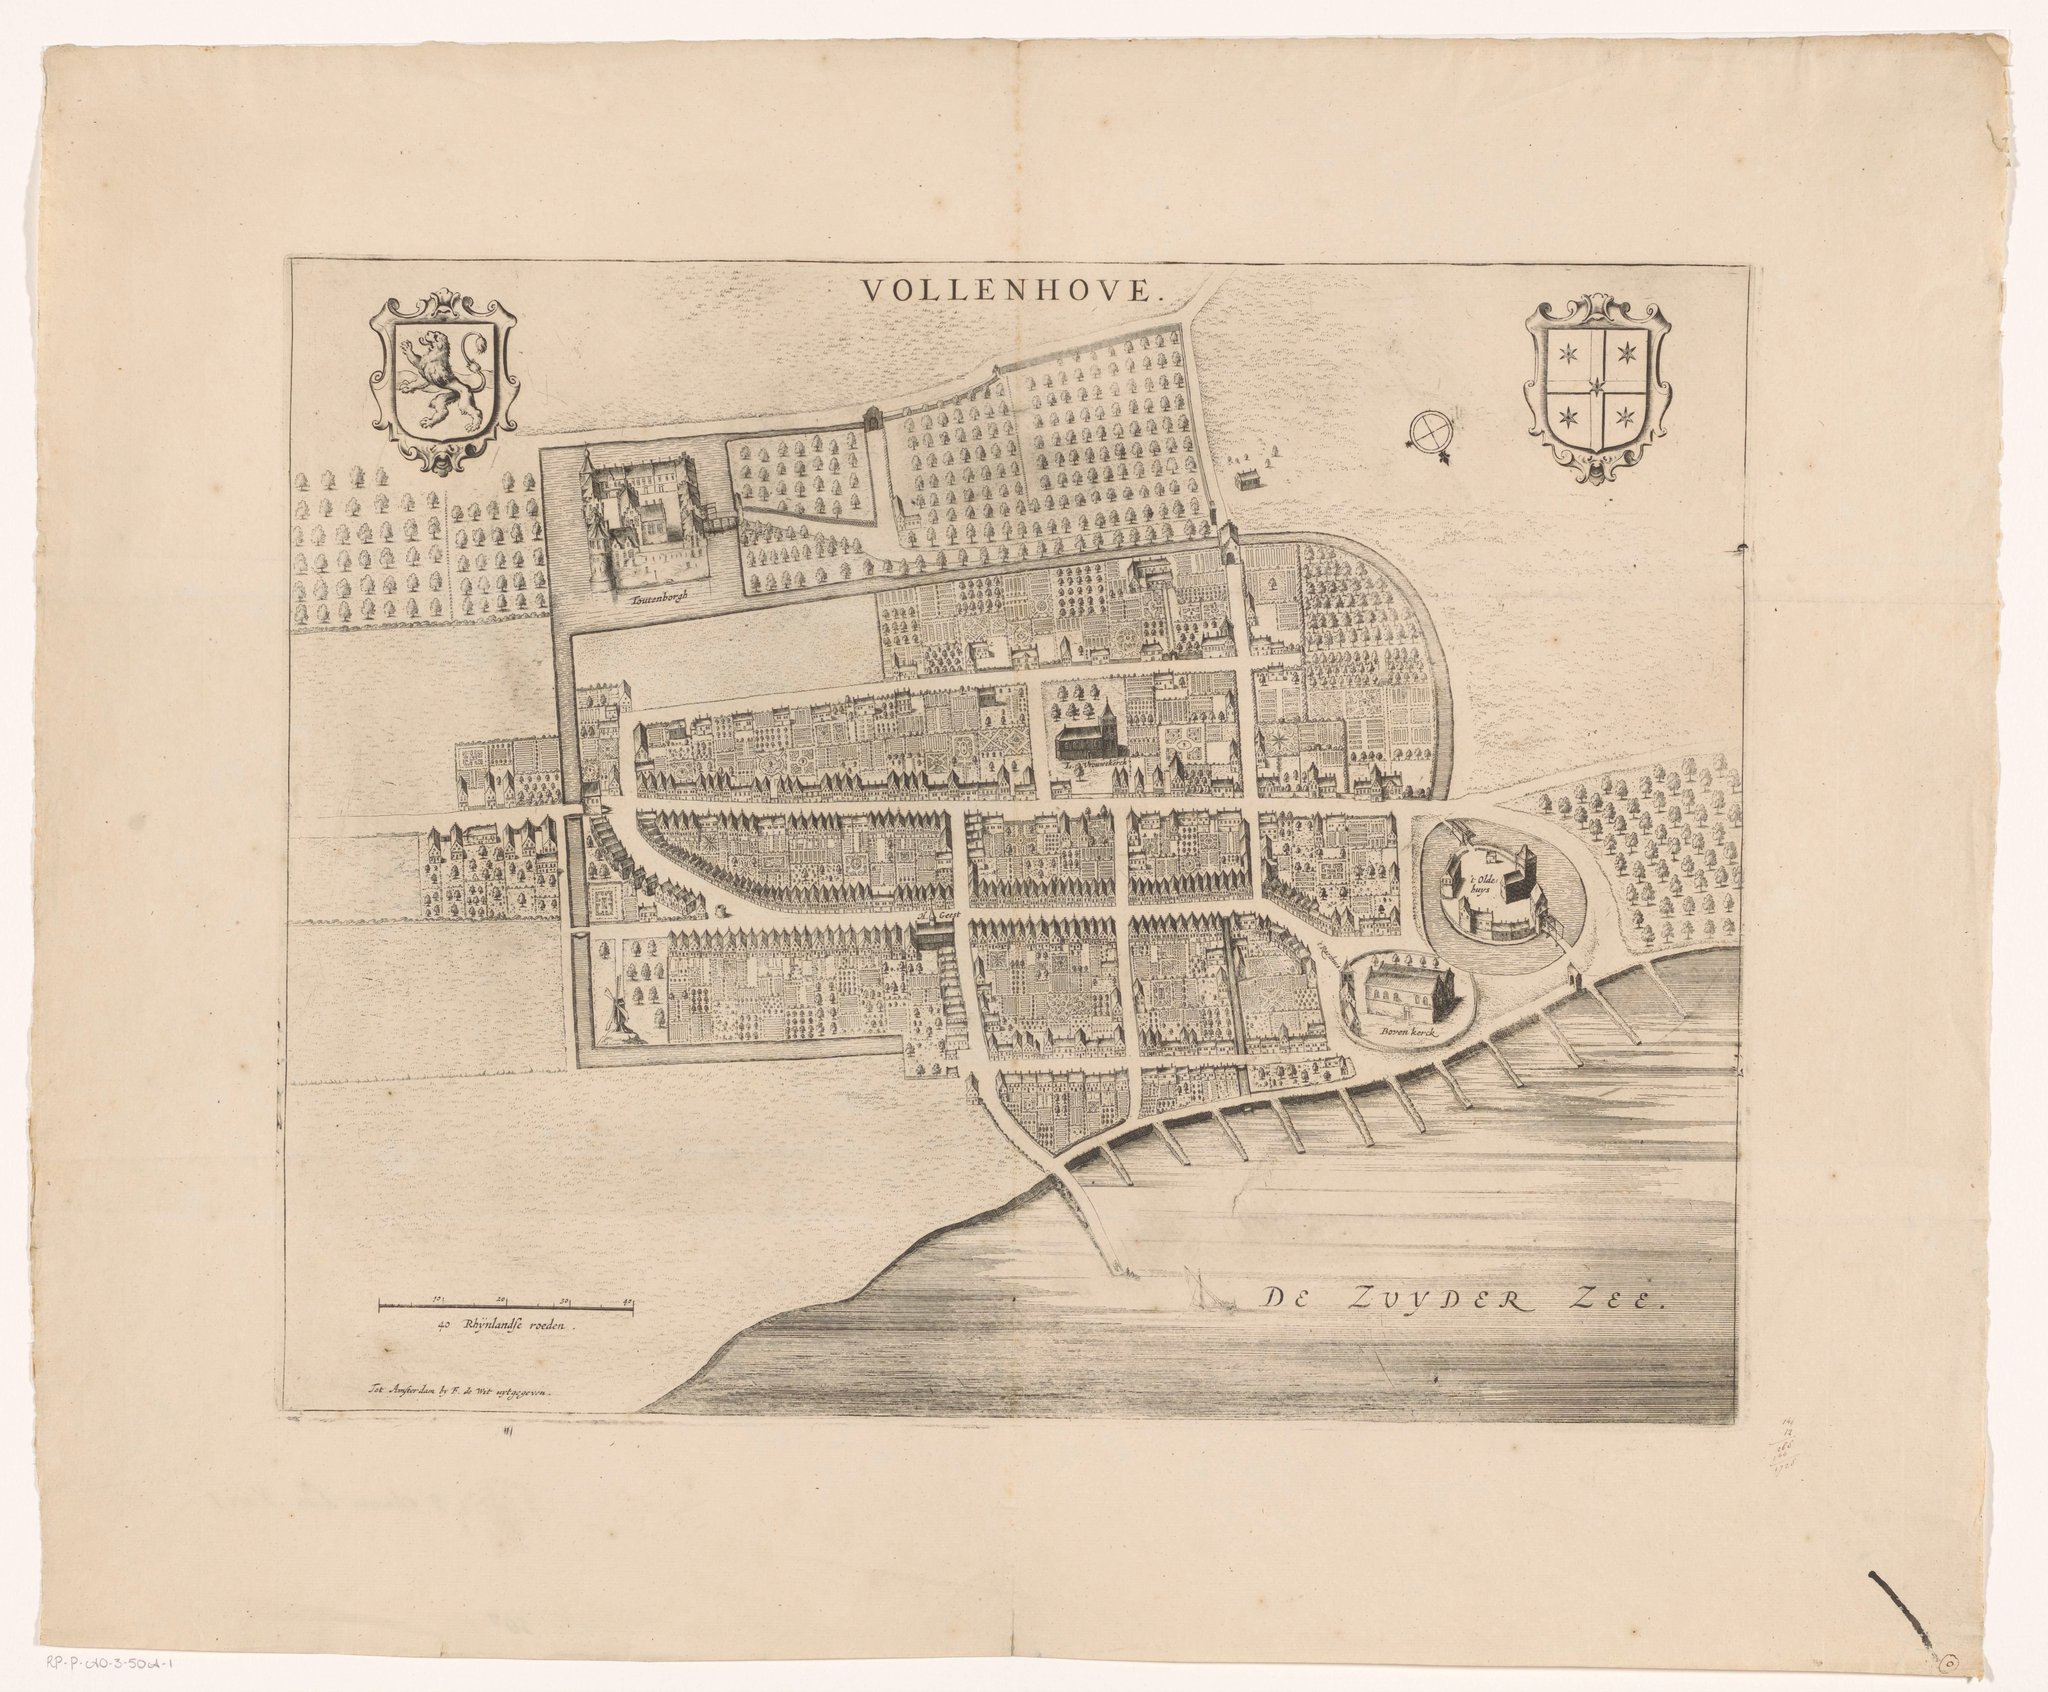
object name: print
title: Plattegrond van Vollenhove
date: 1649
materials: paper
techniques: engraving, etching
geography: amsterdam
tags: coat of arms (as symbol of the state, etc.), maps of cities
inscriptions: collector's mark: Lugt 19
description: Plattegrond in vogelvluchtperspectief. Linksboven het wapen van Overijssel. Linksonder een schaalstok: 40 Rhijnlandse roeden. Rechtsboven het wapen van Vollenhove.